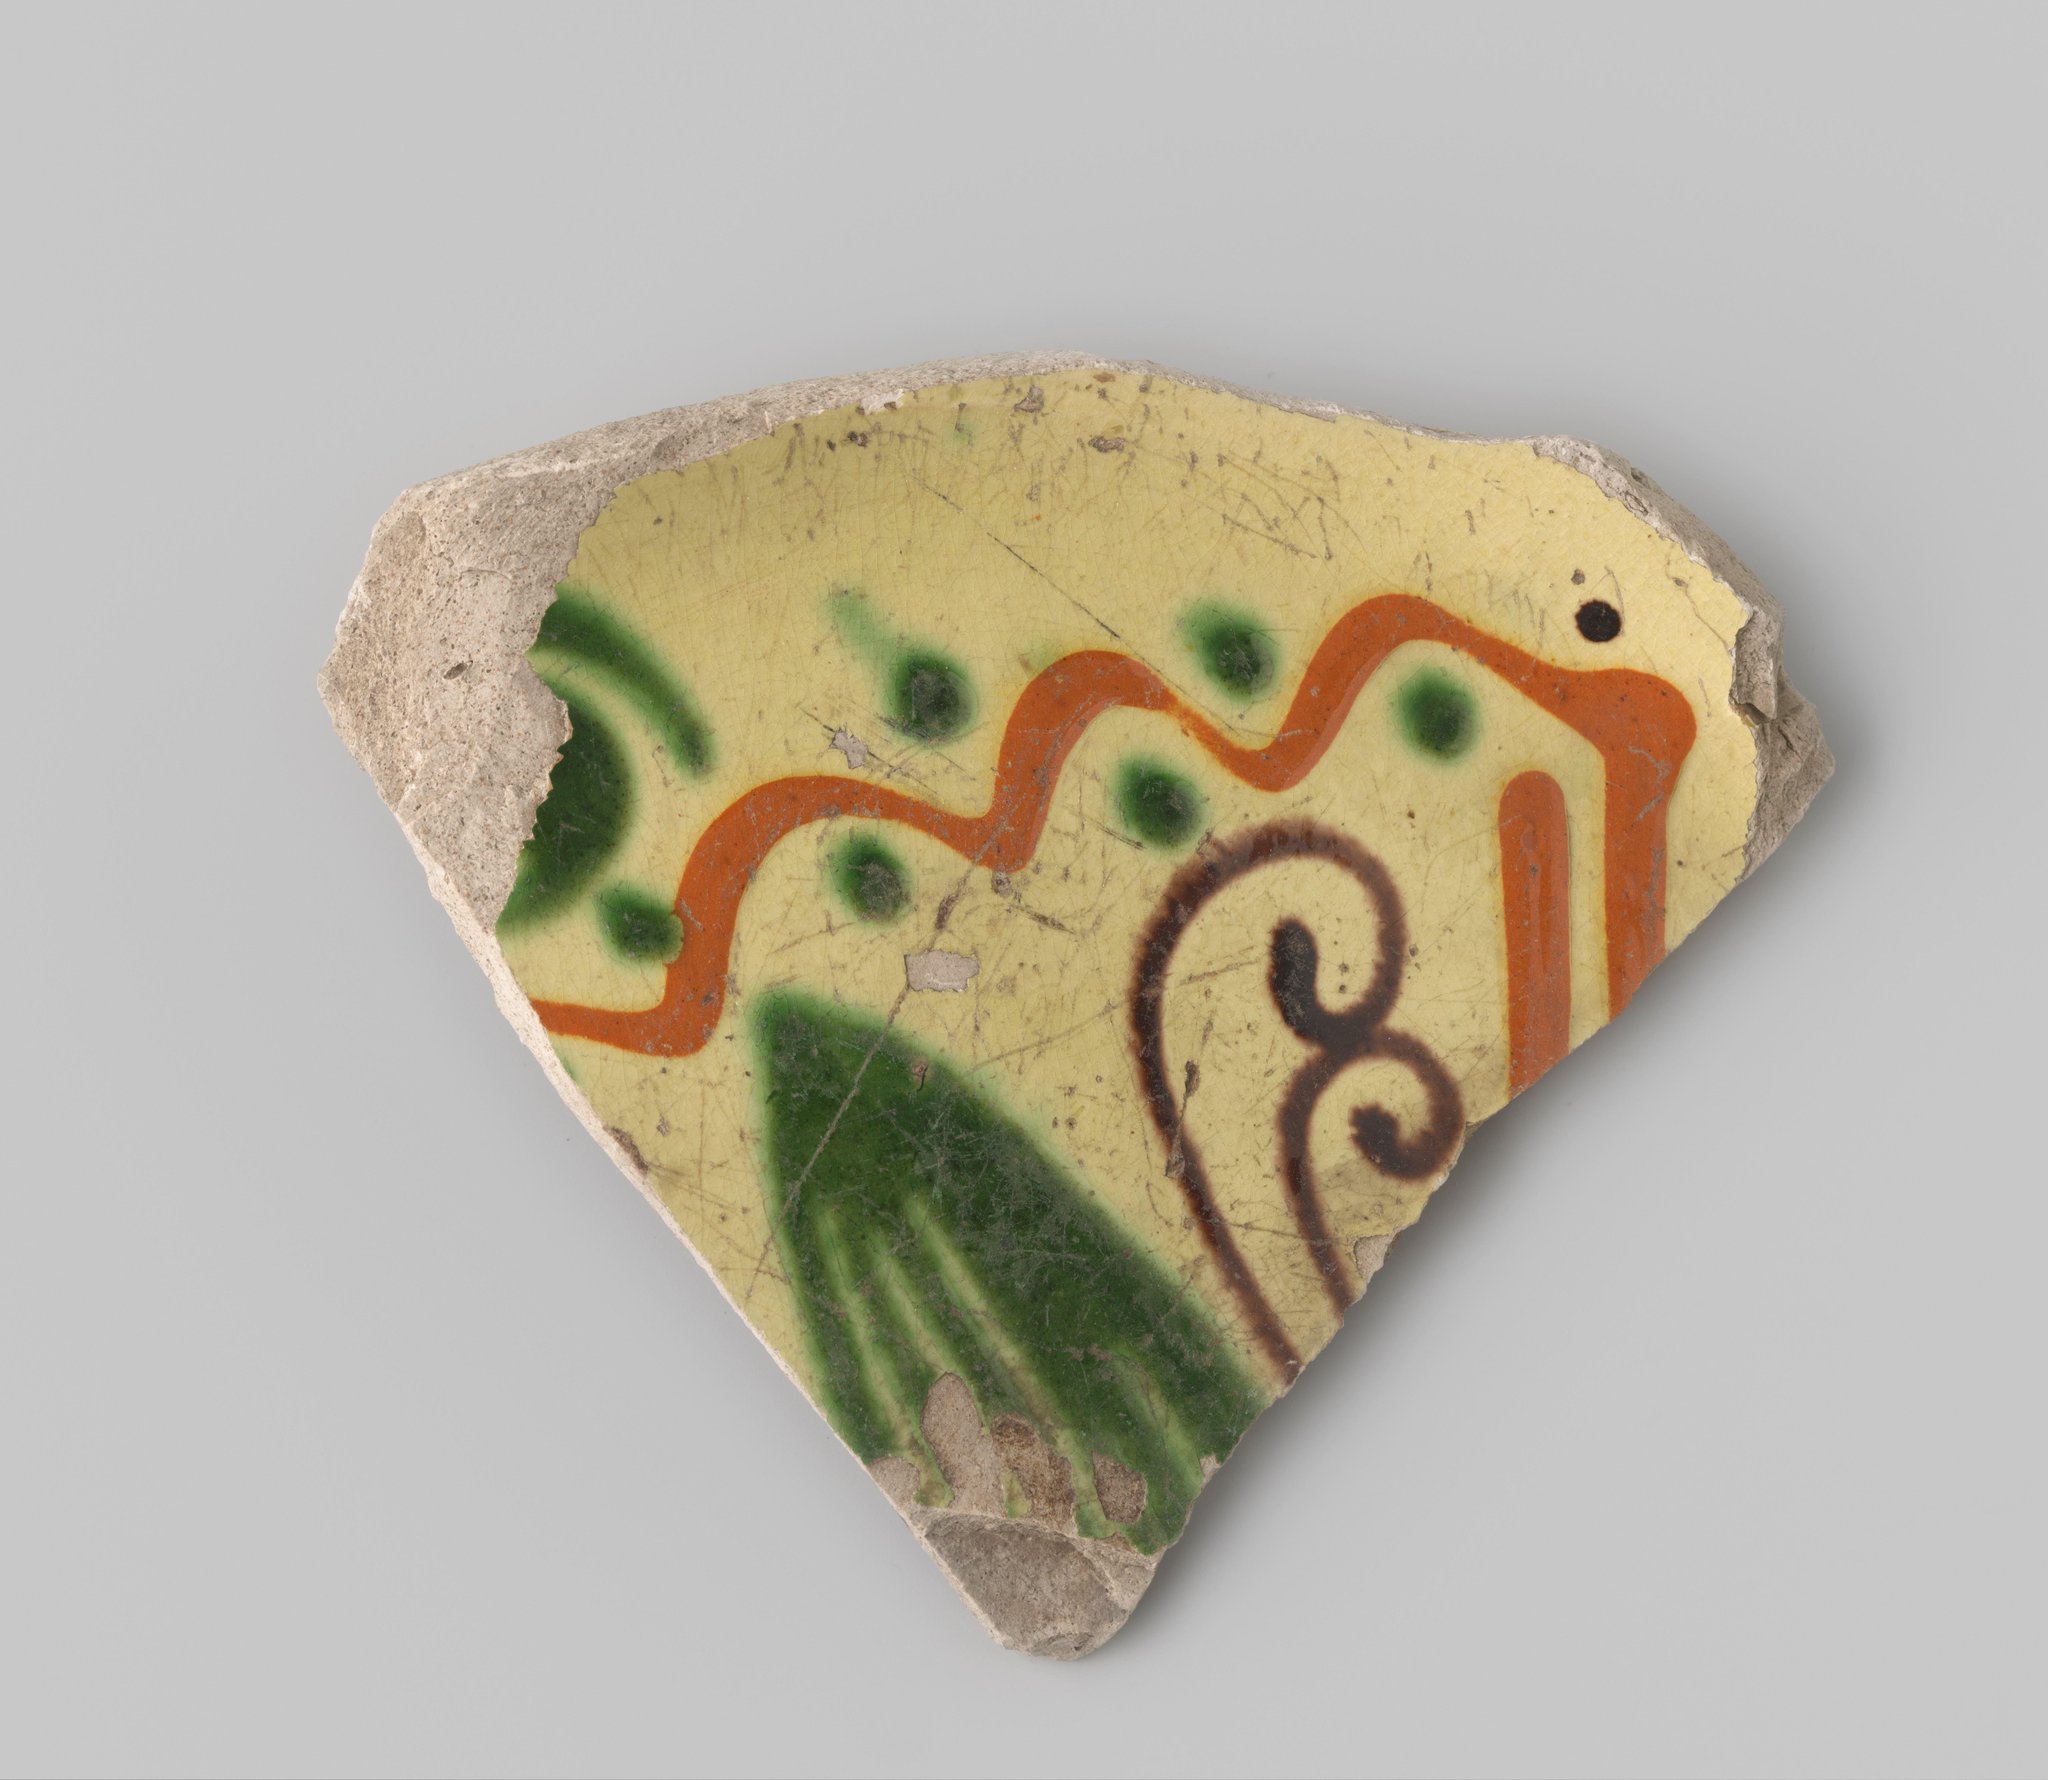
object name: fragment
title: Scherf van een bord van witbakkend aardewerk, met aan de voorzijde geel glazuur voorzien van versiering in oranje, groen en bruin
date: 1500-1899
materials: earthenware, glaze